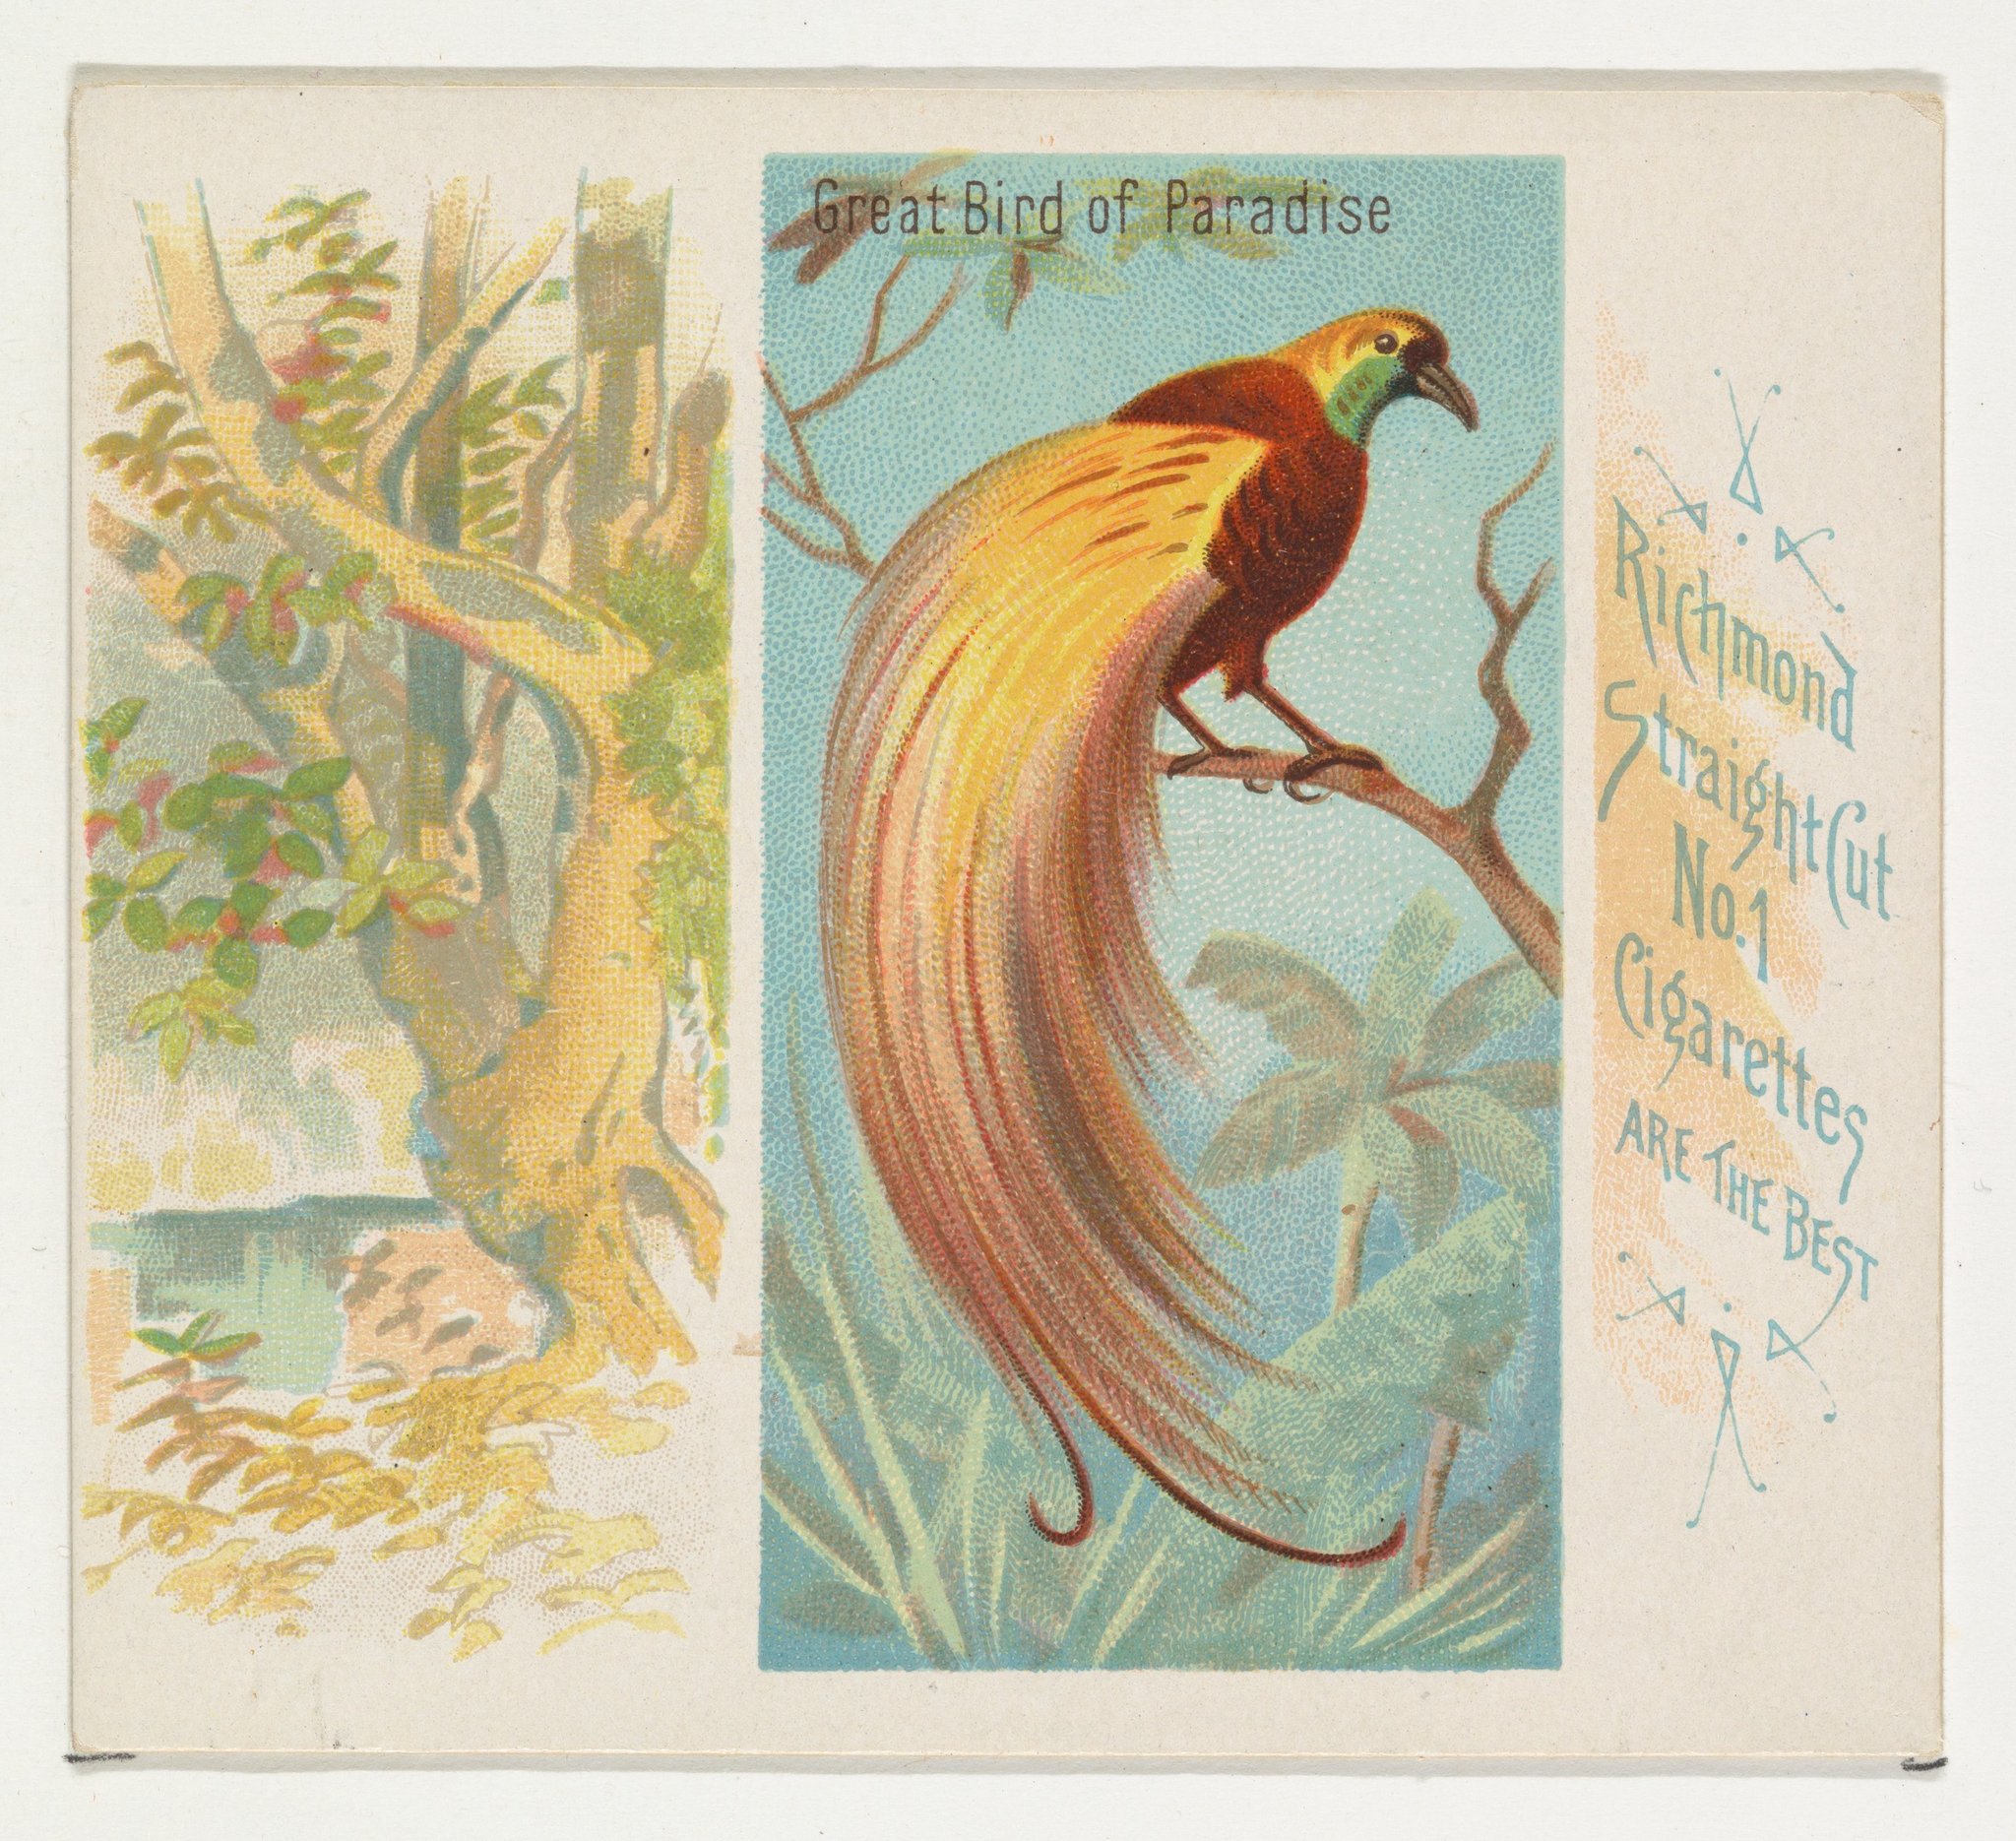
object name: print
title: Great Bird of Paradise, from Birds of the Tropics series (N38) for Allen & Ginter Cigarettes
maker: allen & ginter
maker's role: publisher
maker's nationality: american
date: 1889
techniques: color lithograph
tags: birds